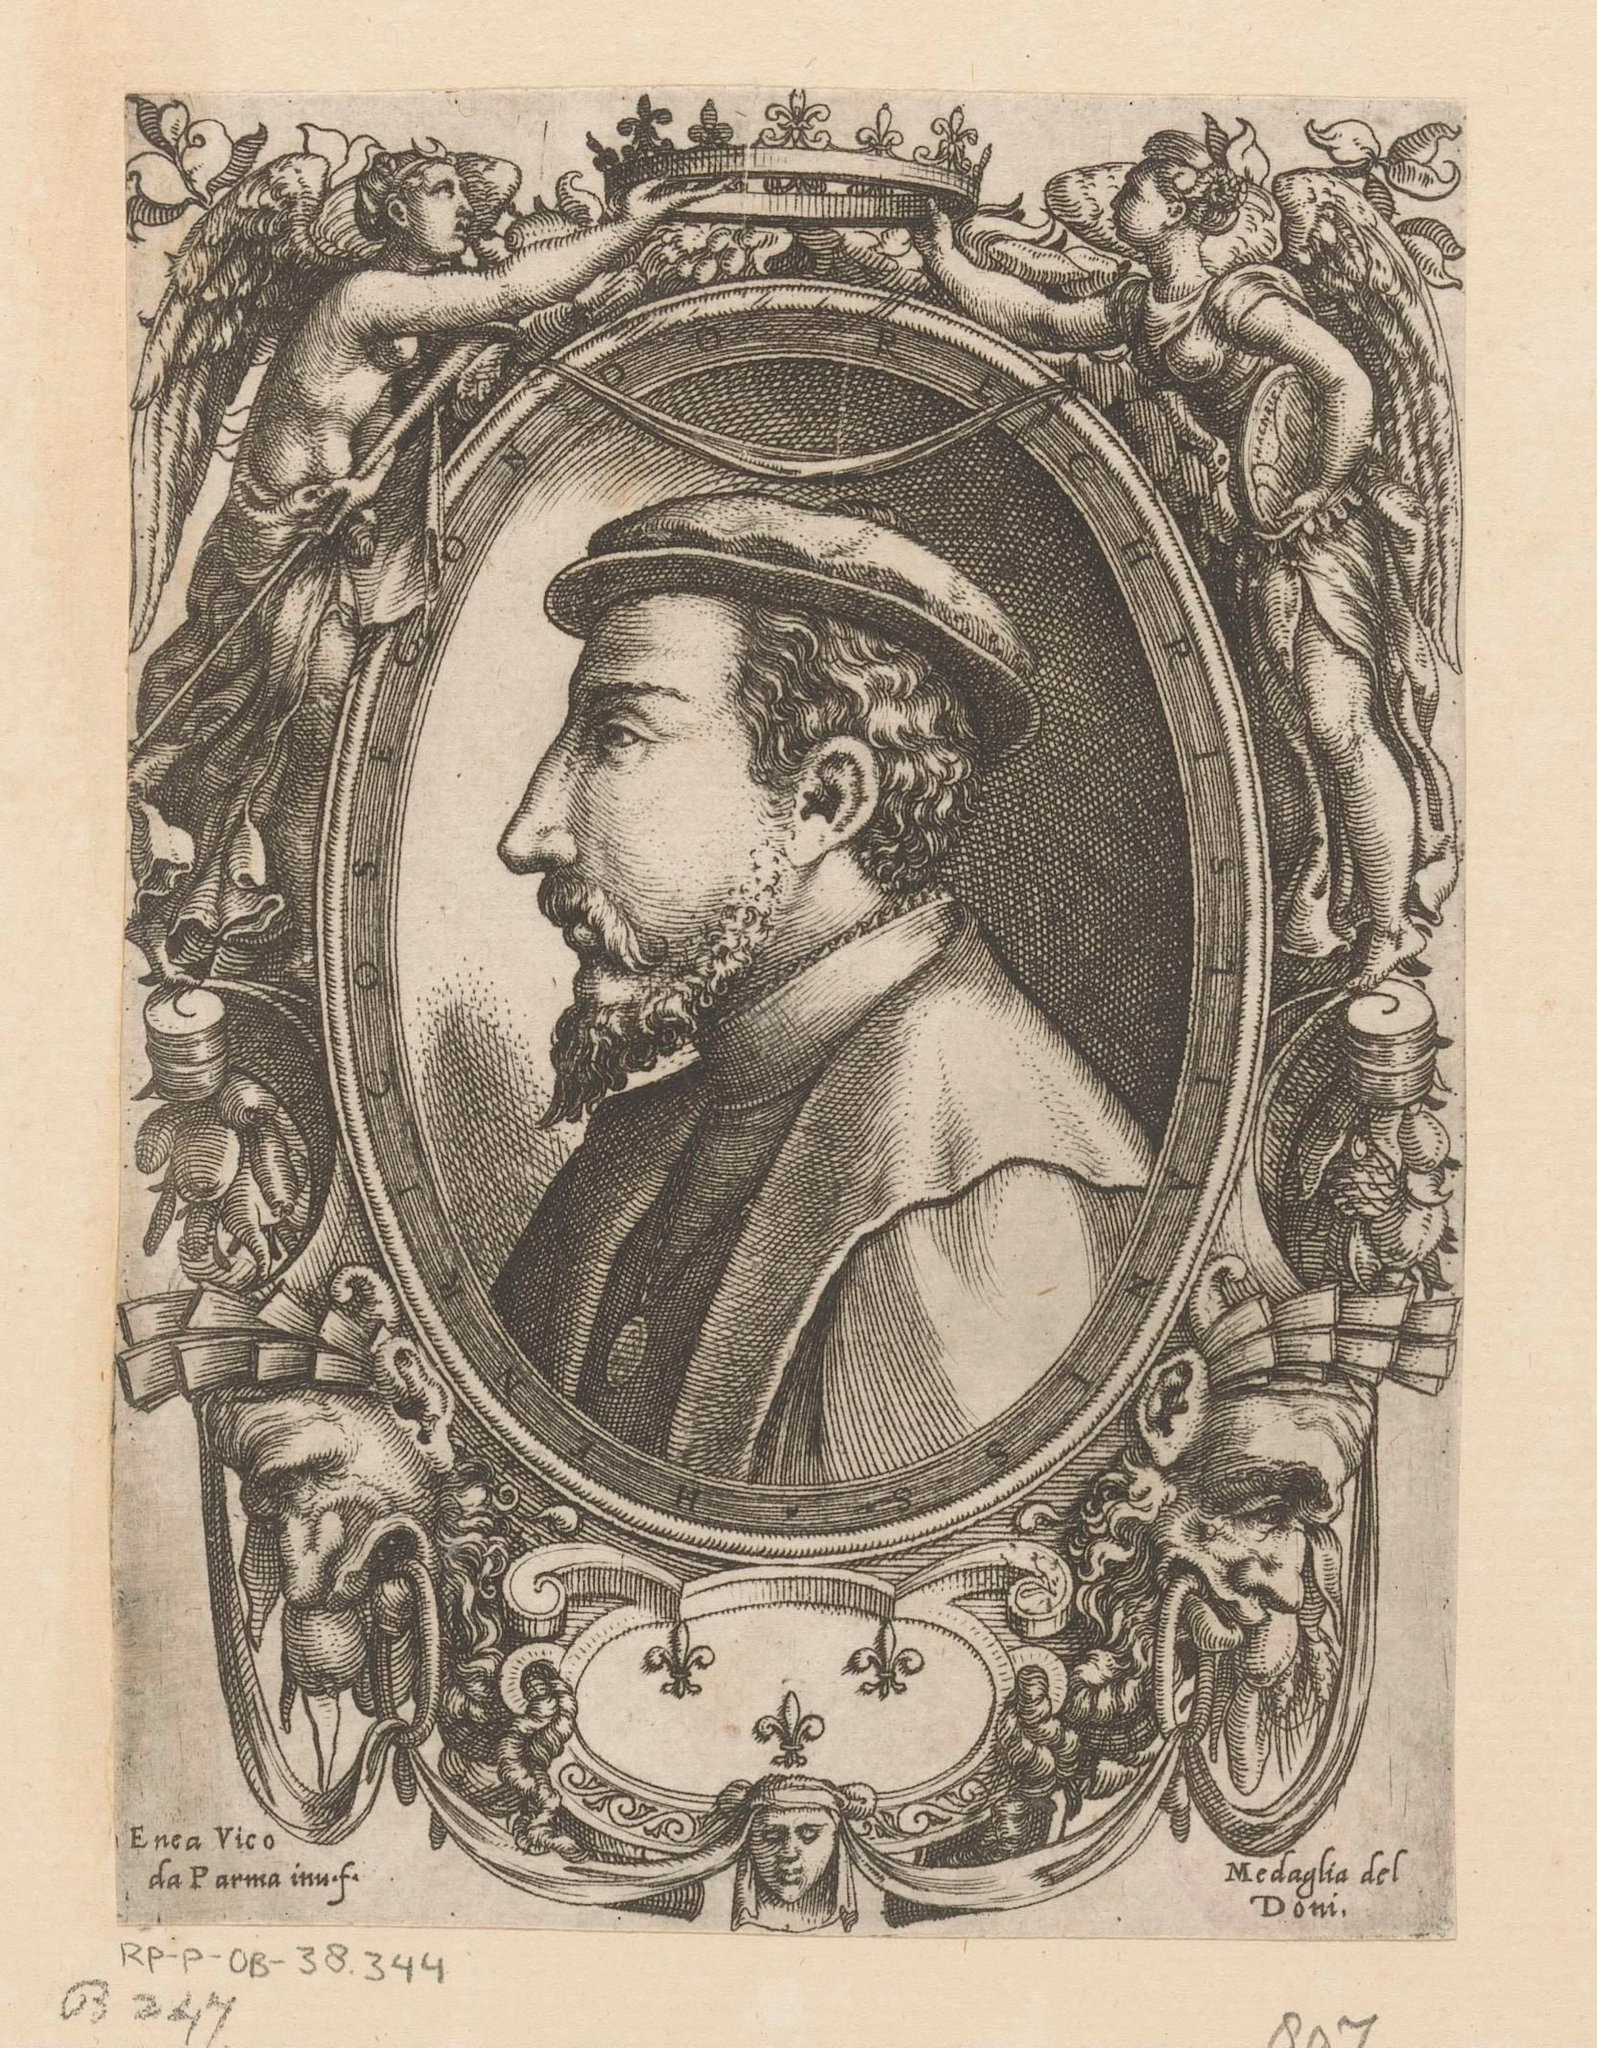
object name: print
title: Penningen van Anton Francesco Doni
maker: enea vico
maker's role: draughtsman, print maker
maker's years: 1523-1567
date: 1550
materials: paper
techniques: engraving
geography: italy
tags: paris, historical persons, ruler, sovereign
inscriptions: collector's mark: Lugt 12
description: Portret van Hendrik II, gevat in een geornamenteerde lijst.